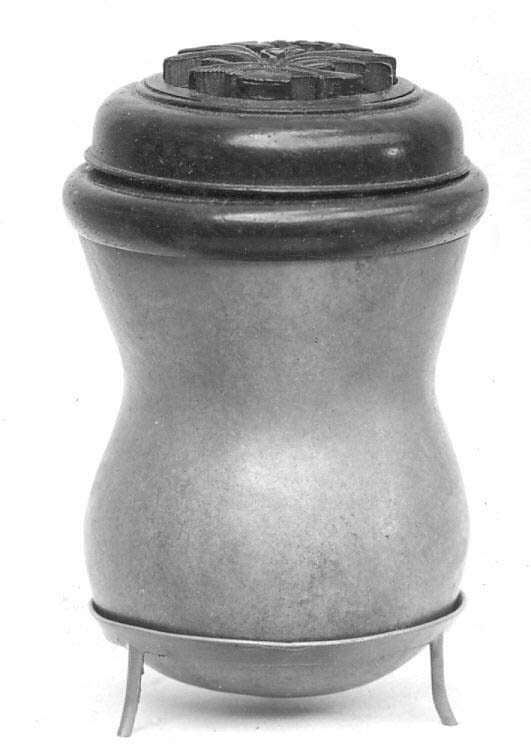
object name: cricket cage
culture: chinese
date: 1701-1900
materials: wood